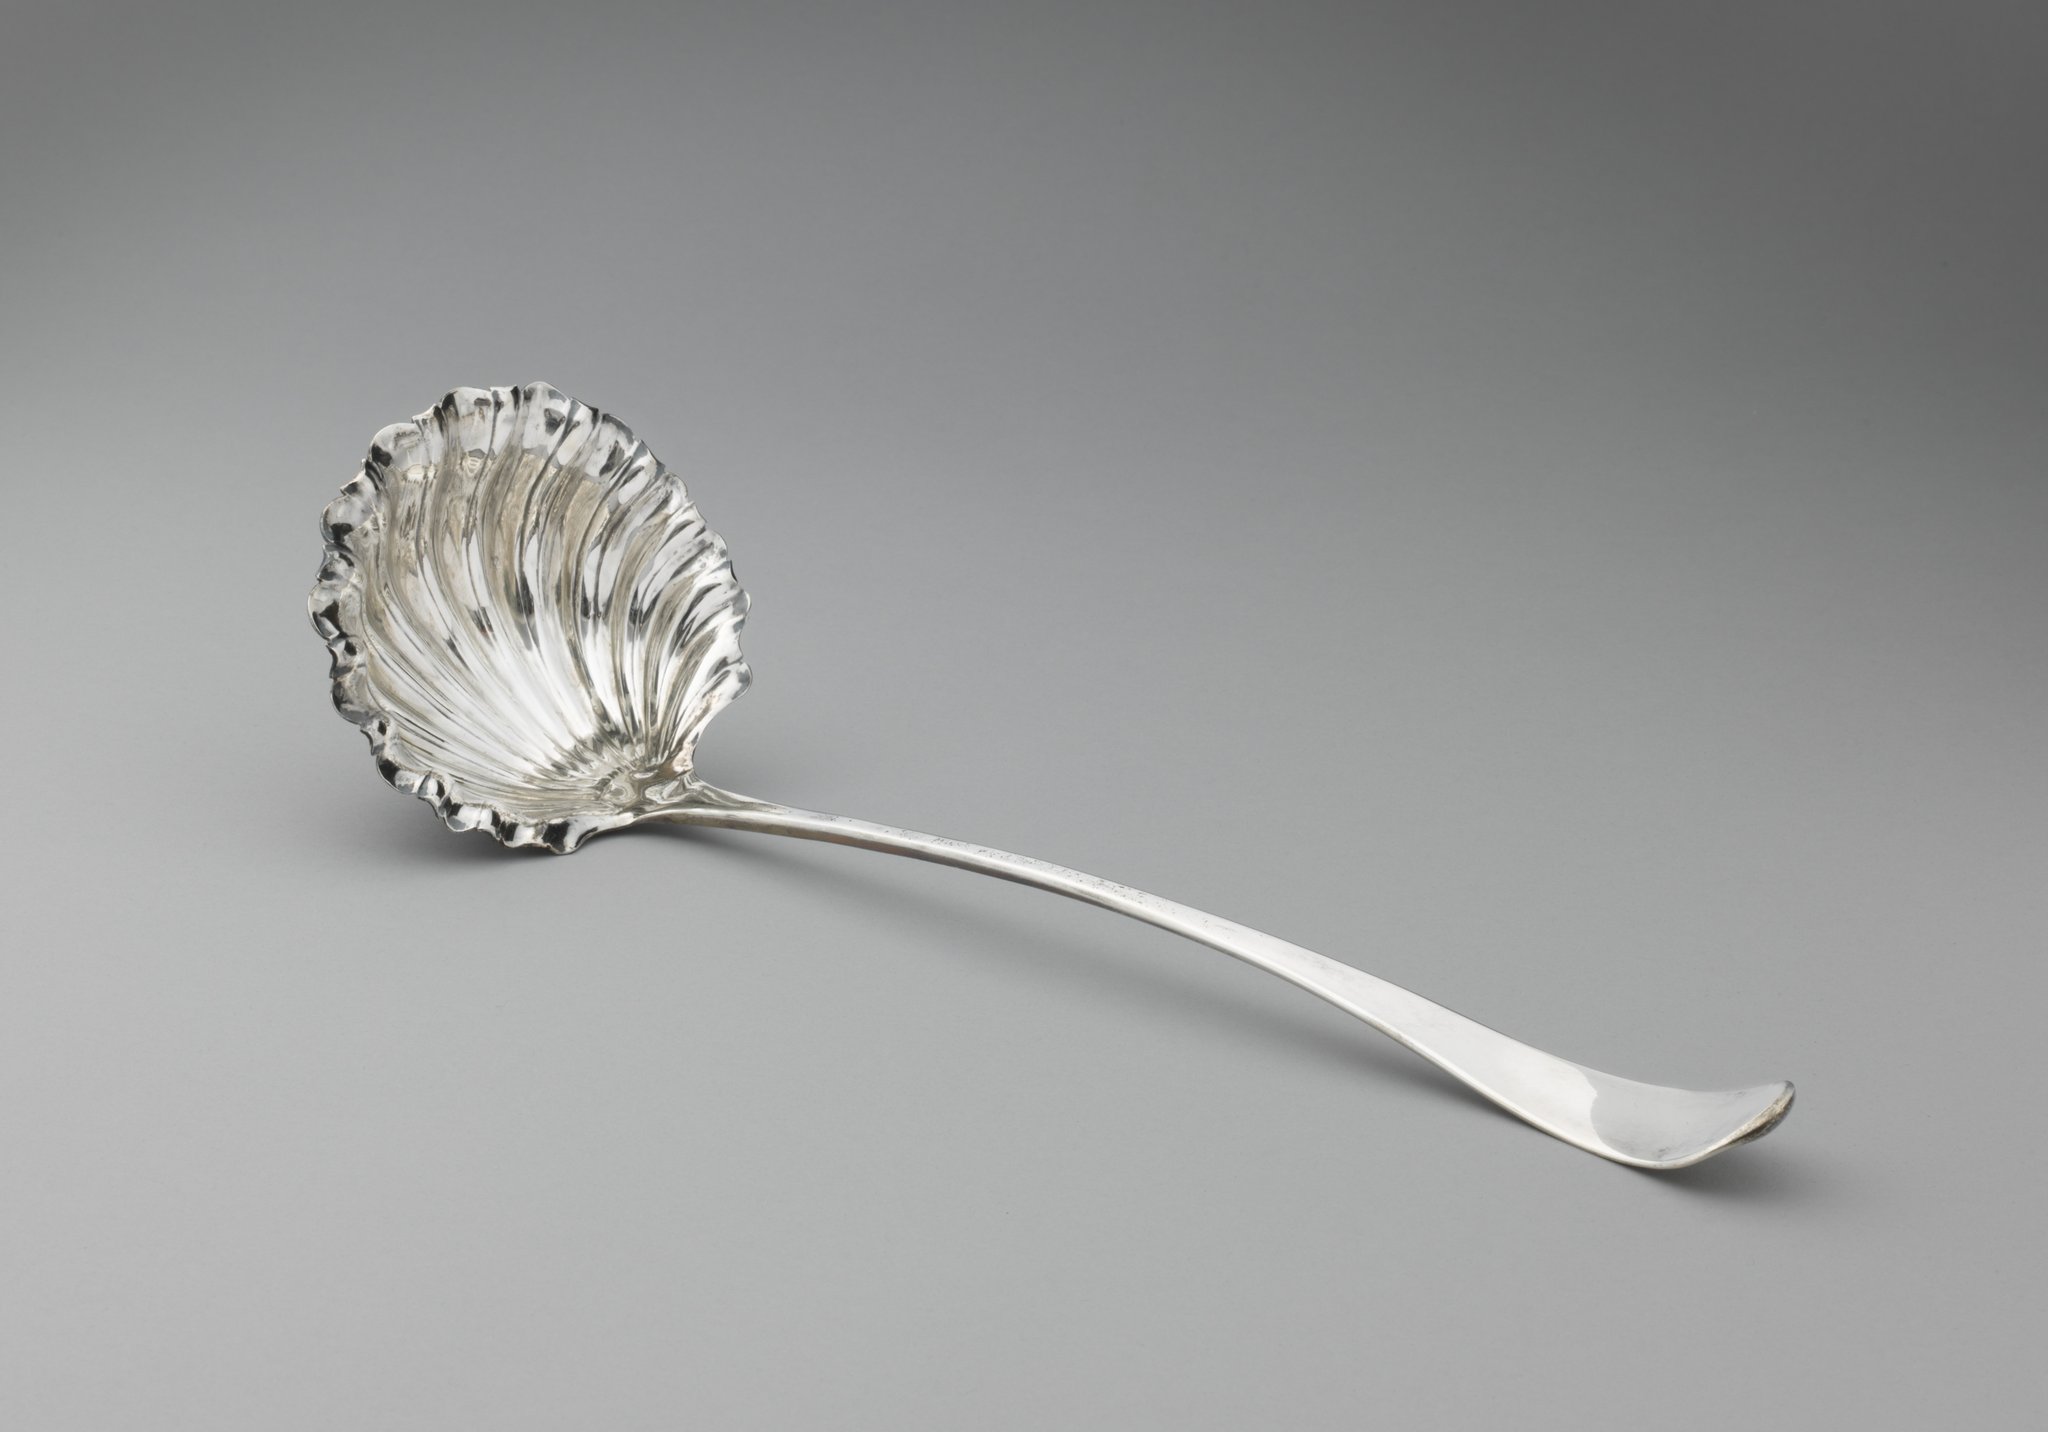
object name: ladle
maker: richard crossley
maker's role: maker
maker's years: 1715-1815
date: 1796-1797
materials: silver